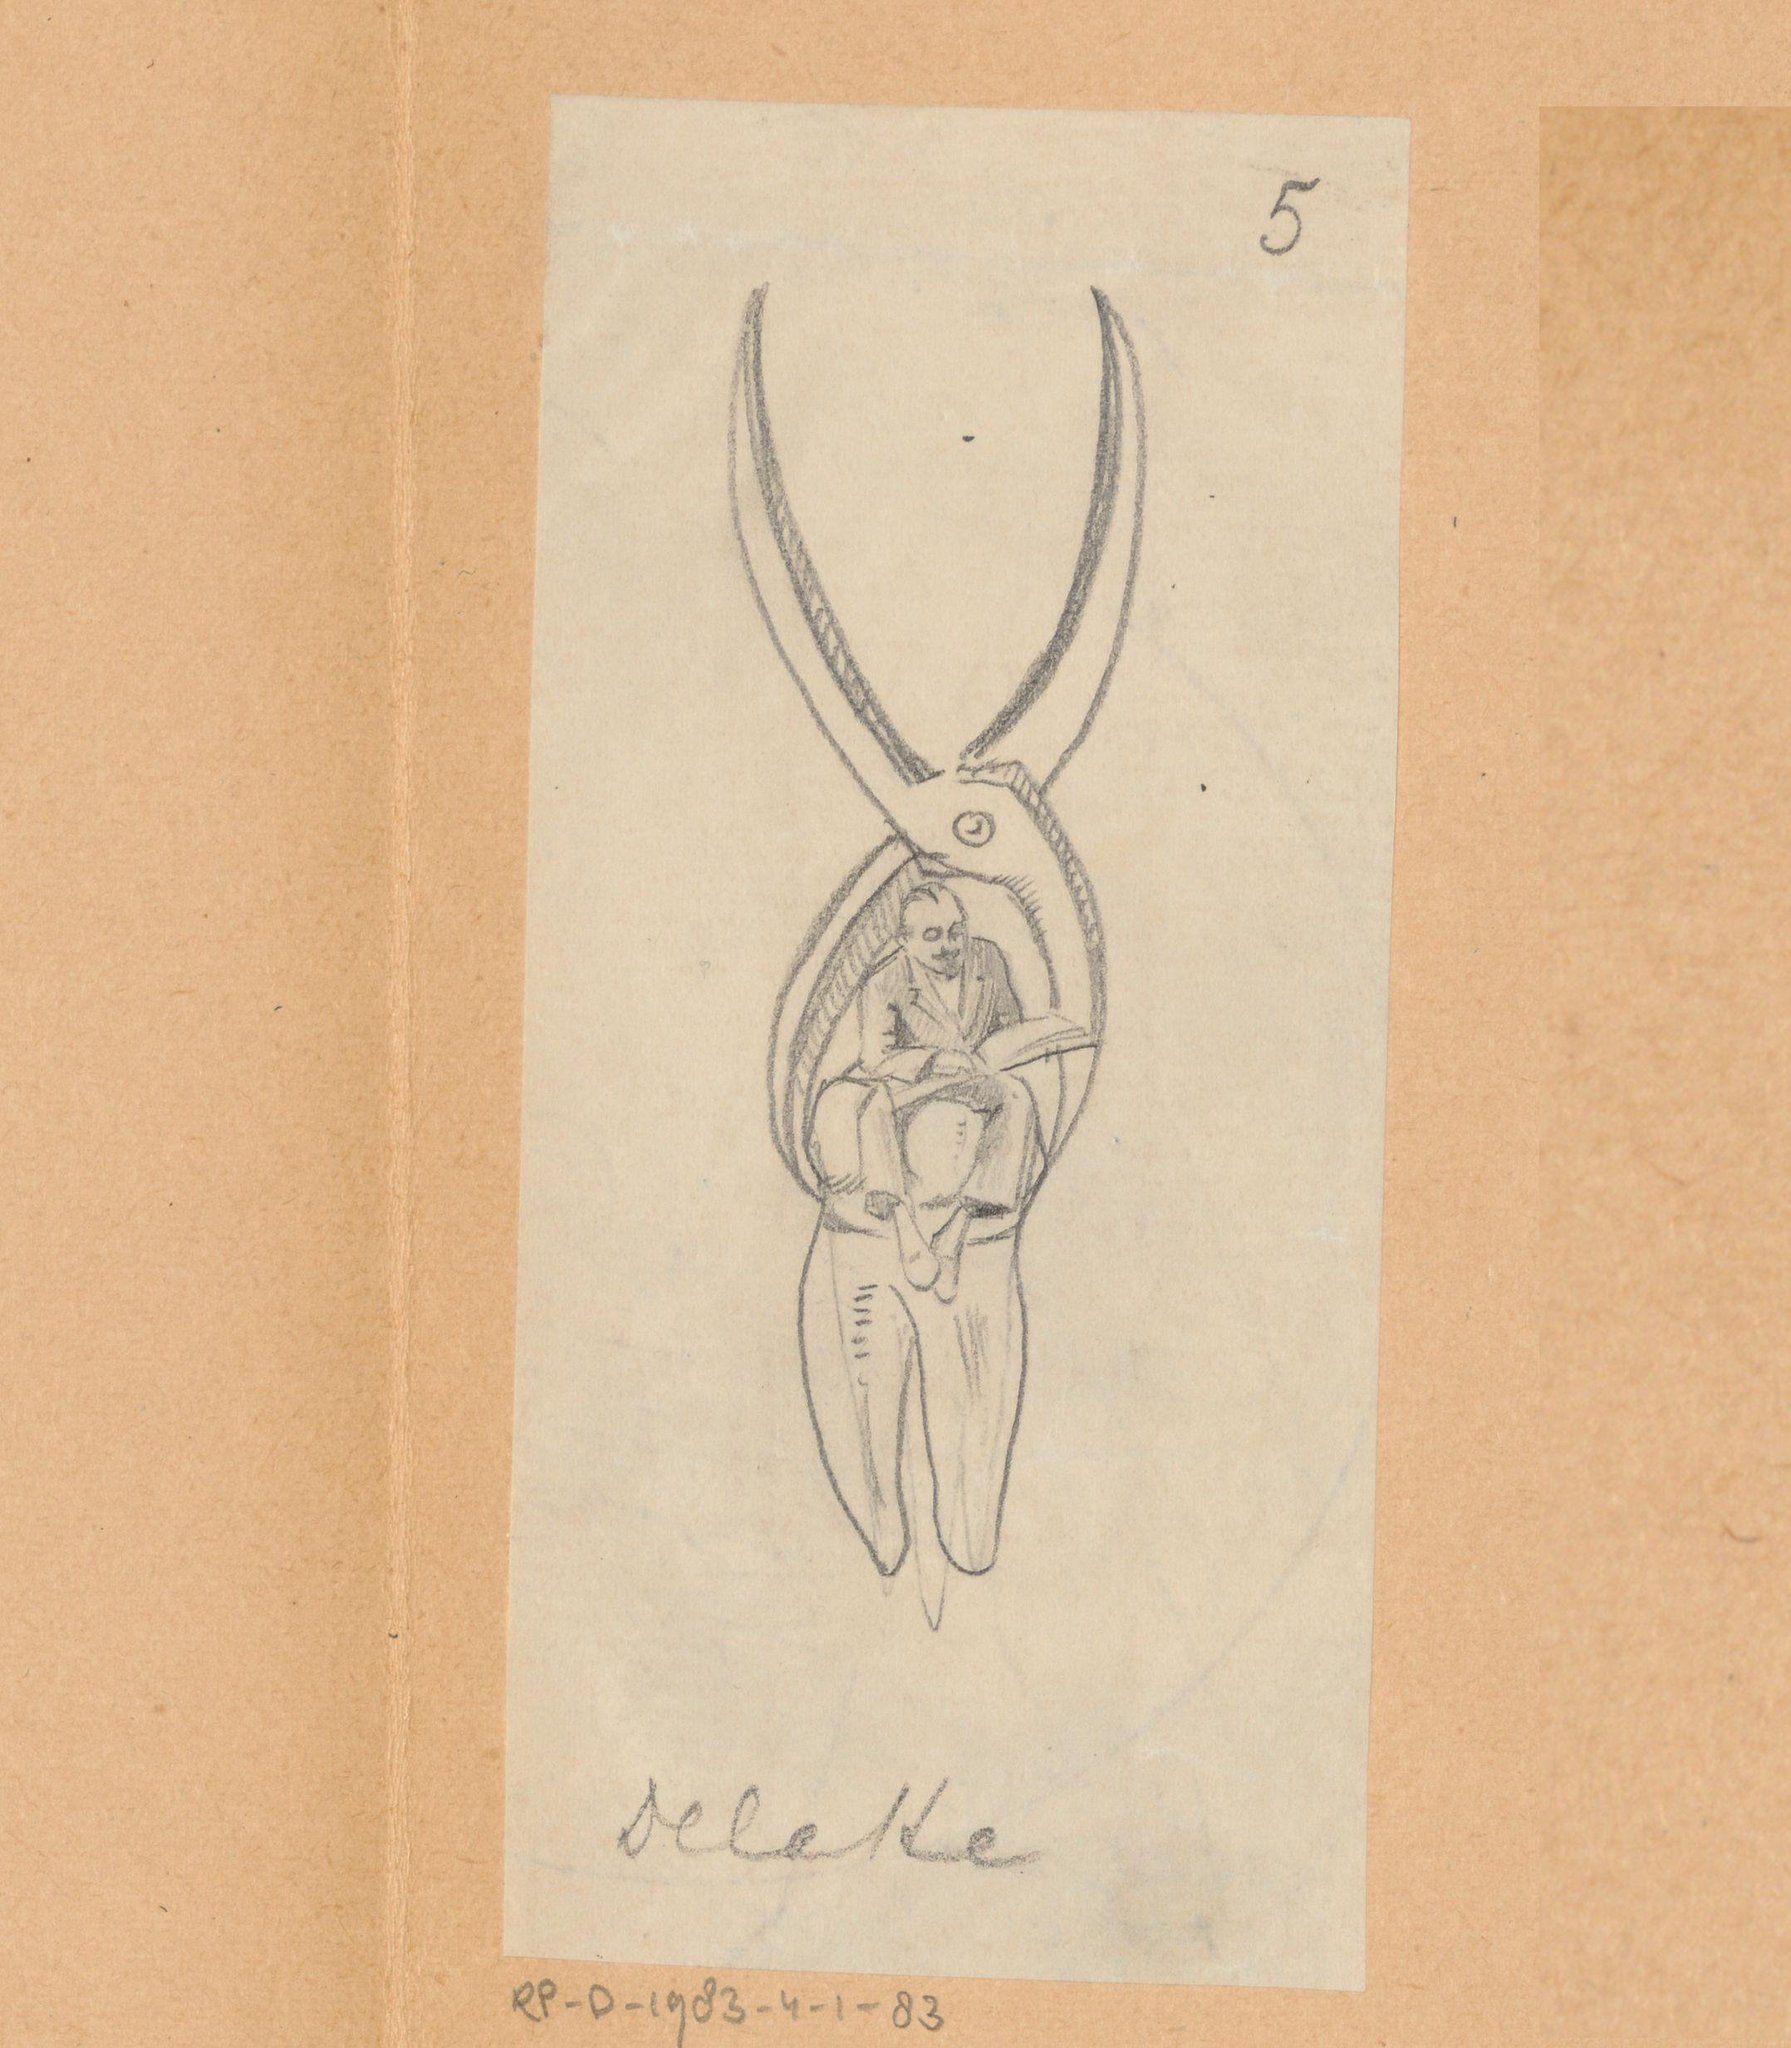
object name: design drawing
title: Ontwerptekening voor ex libris van Lucien Delatte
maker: otto verhagen (i)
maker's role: draughtsman, print maker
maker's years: 1885-1951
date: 1933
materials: paper, pencil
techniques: drawing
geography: netherlands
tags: tools, aids, implements ~ crafts and industries: tongs, sitting figure, book, (barber as) dentist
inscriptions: inscription: ‘Delatte’, inscription: ‘5’